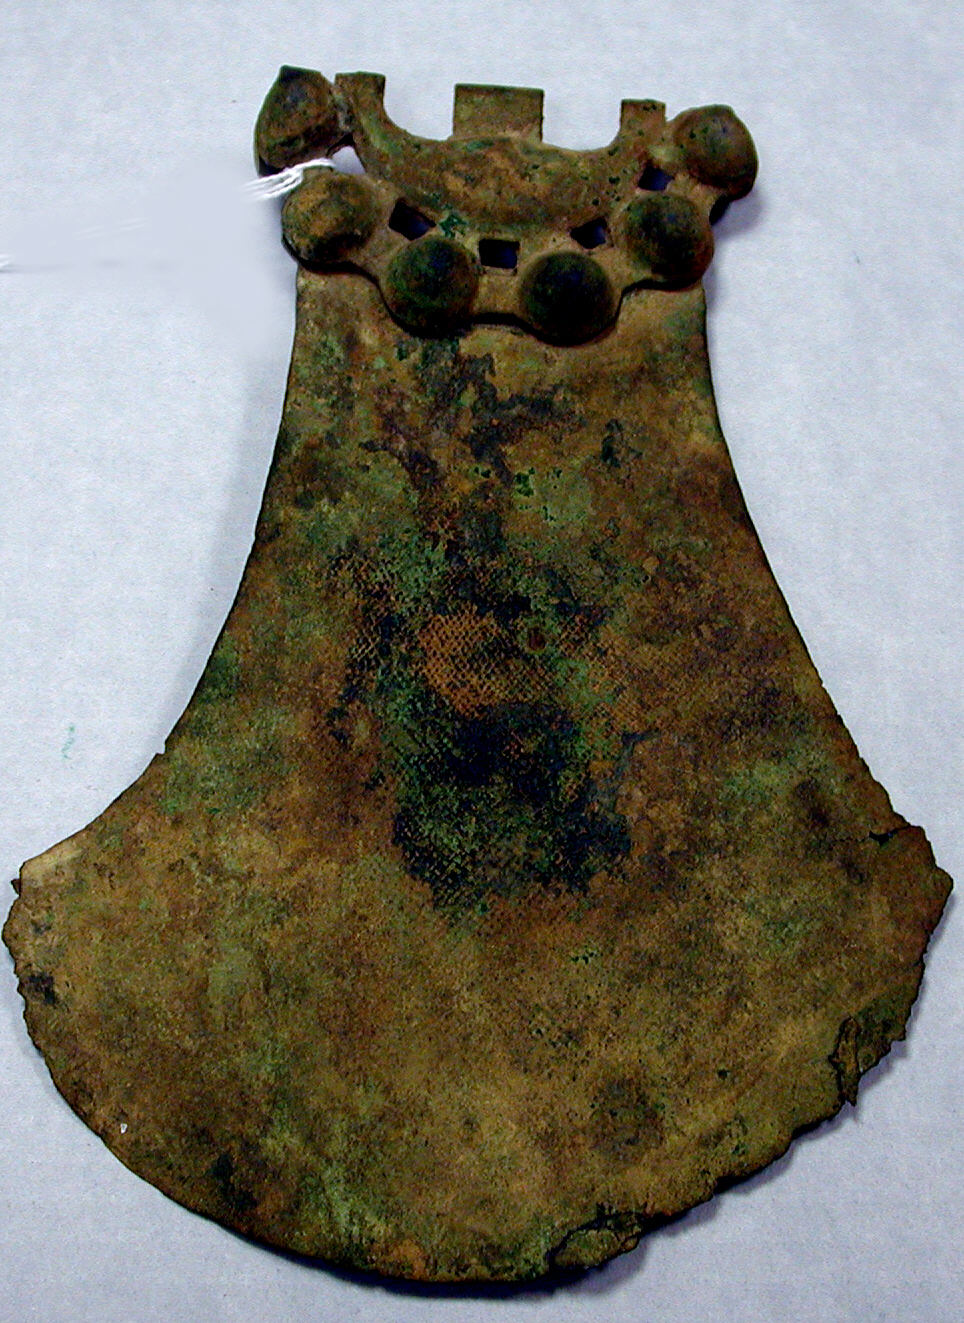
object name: armor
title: Copper Armour Back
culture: moche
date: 101-700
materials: copper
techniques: hammering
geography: peru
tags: armor